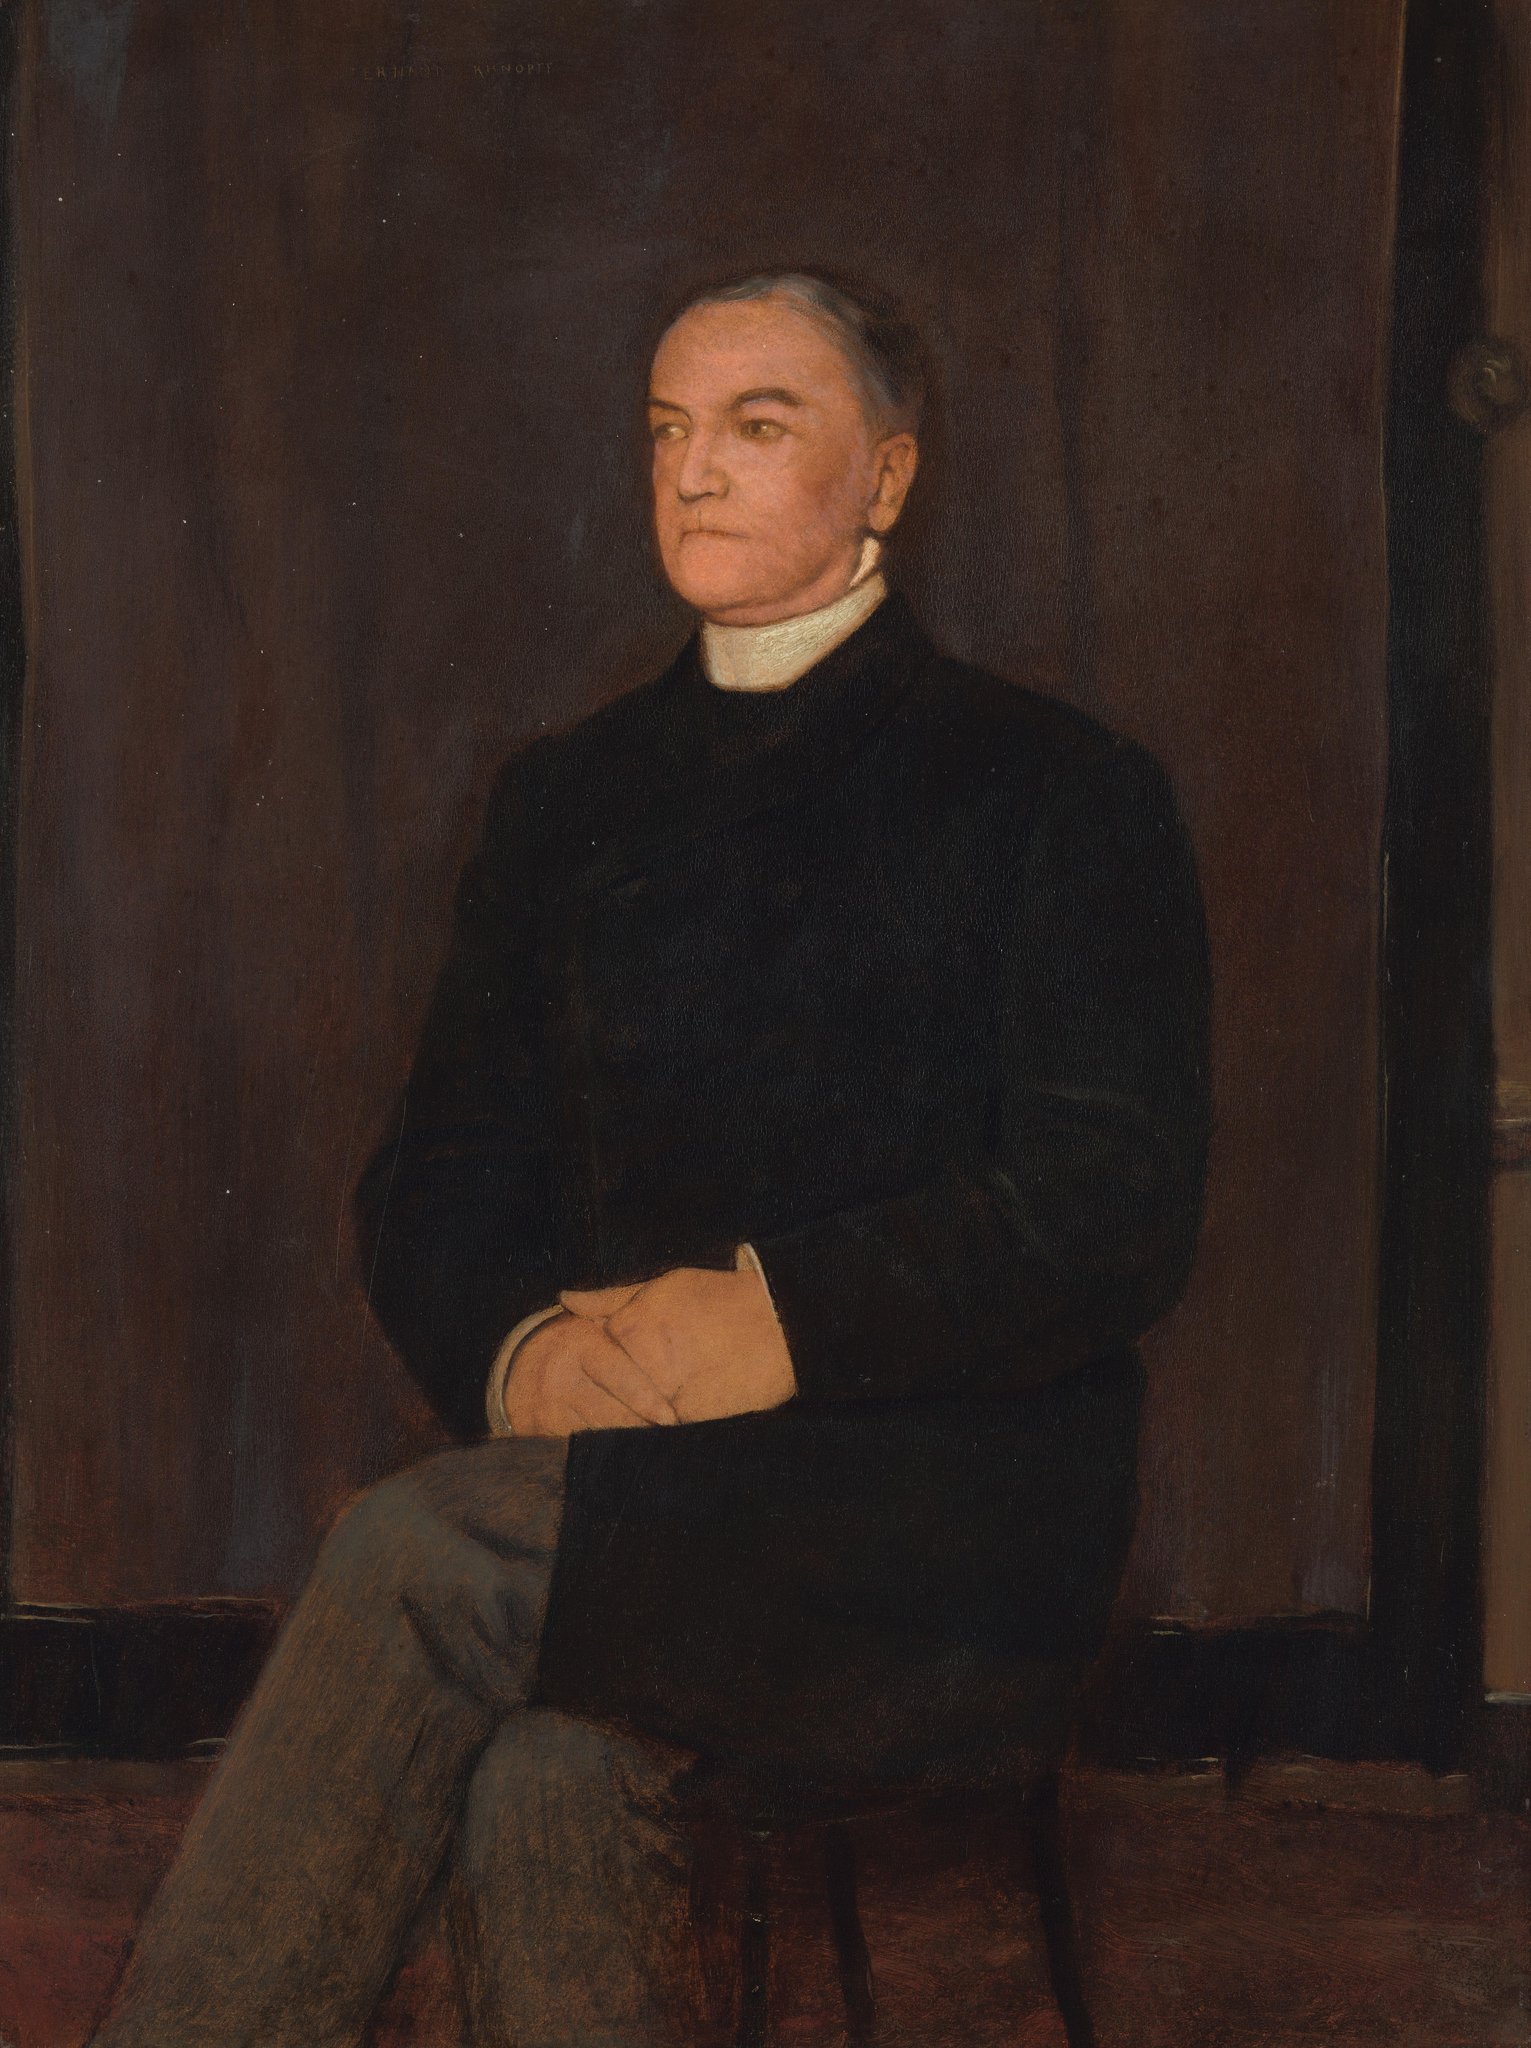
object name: painting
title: Portrait of Augustinus Gerardus Hubertus van Rijckevorsel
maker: fernand khnopff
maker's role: draughtsman, print maker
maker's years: 1858-1921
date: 1888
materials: oil, paint, panel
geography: den bosch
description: Van Rijckevorsel commissioned the Belgian painter Fernand Khnopff to paint portraits of himself and his wife Maria, the artist’s aunt. The poetic quality of Khnopff’s paintings had won him popularity as a portraitist among the Brussels bourgeoisie in 1888. From the correspondence about the commission, it appears that Khnopff chose these openwork frames, inspired by Renaissance models, himself.